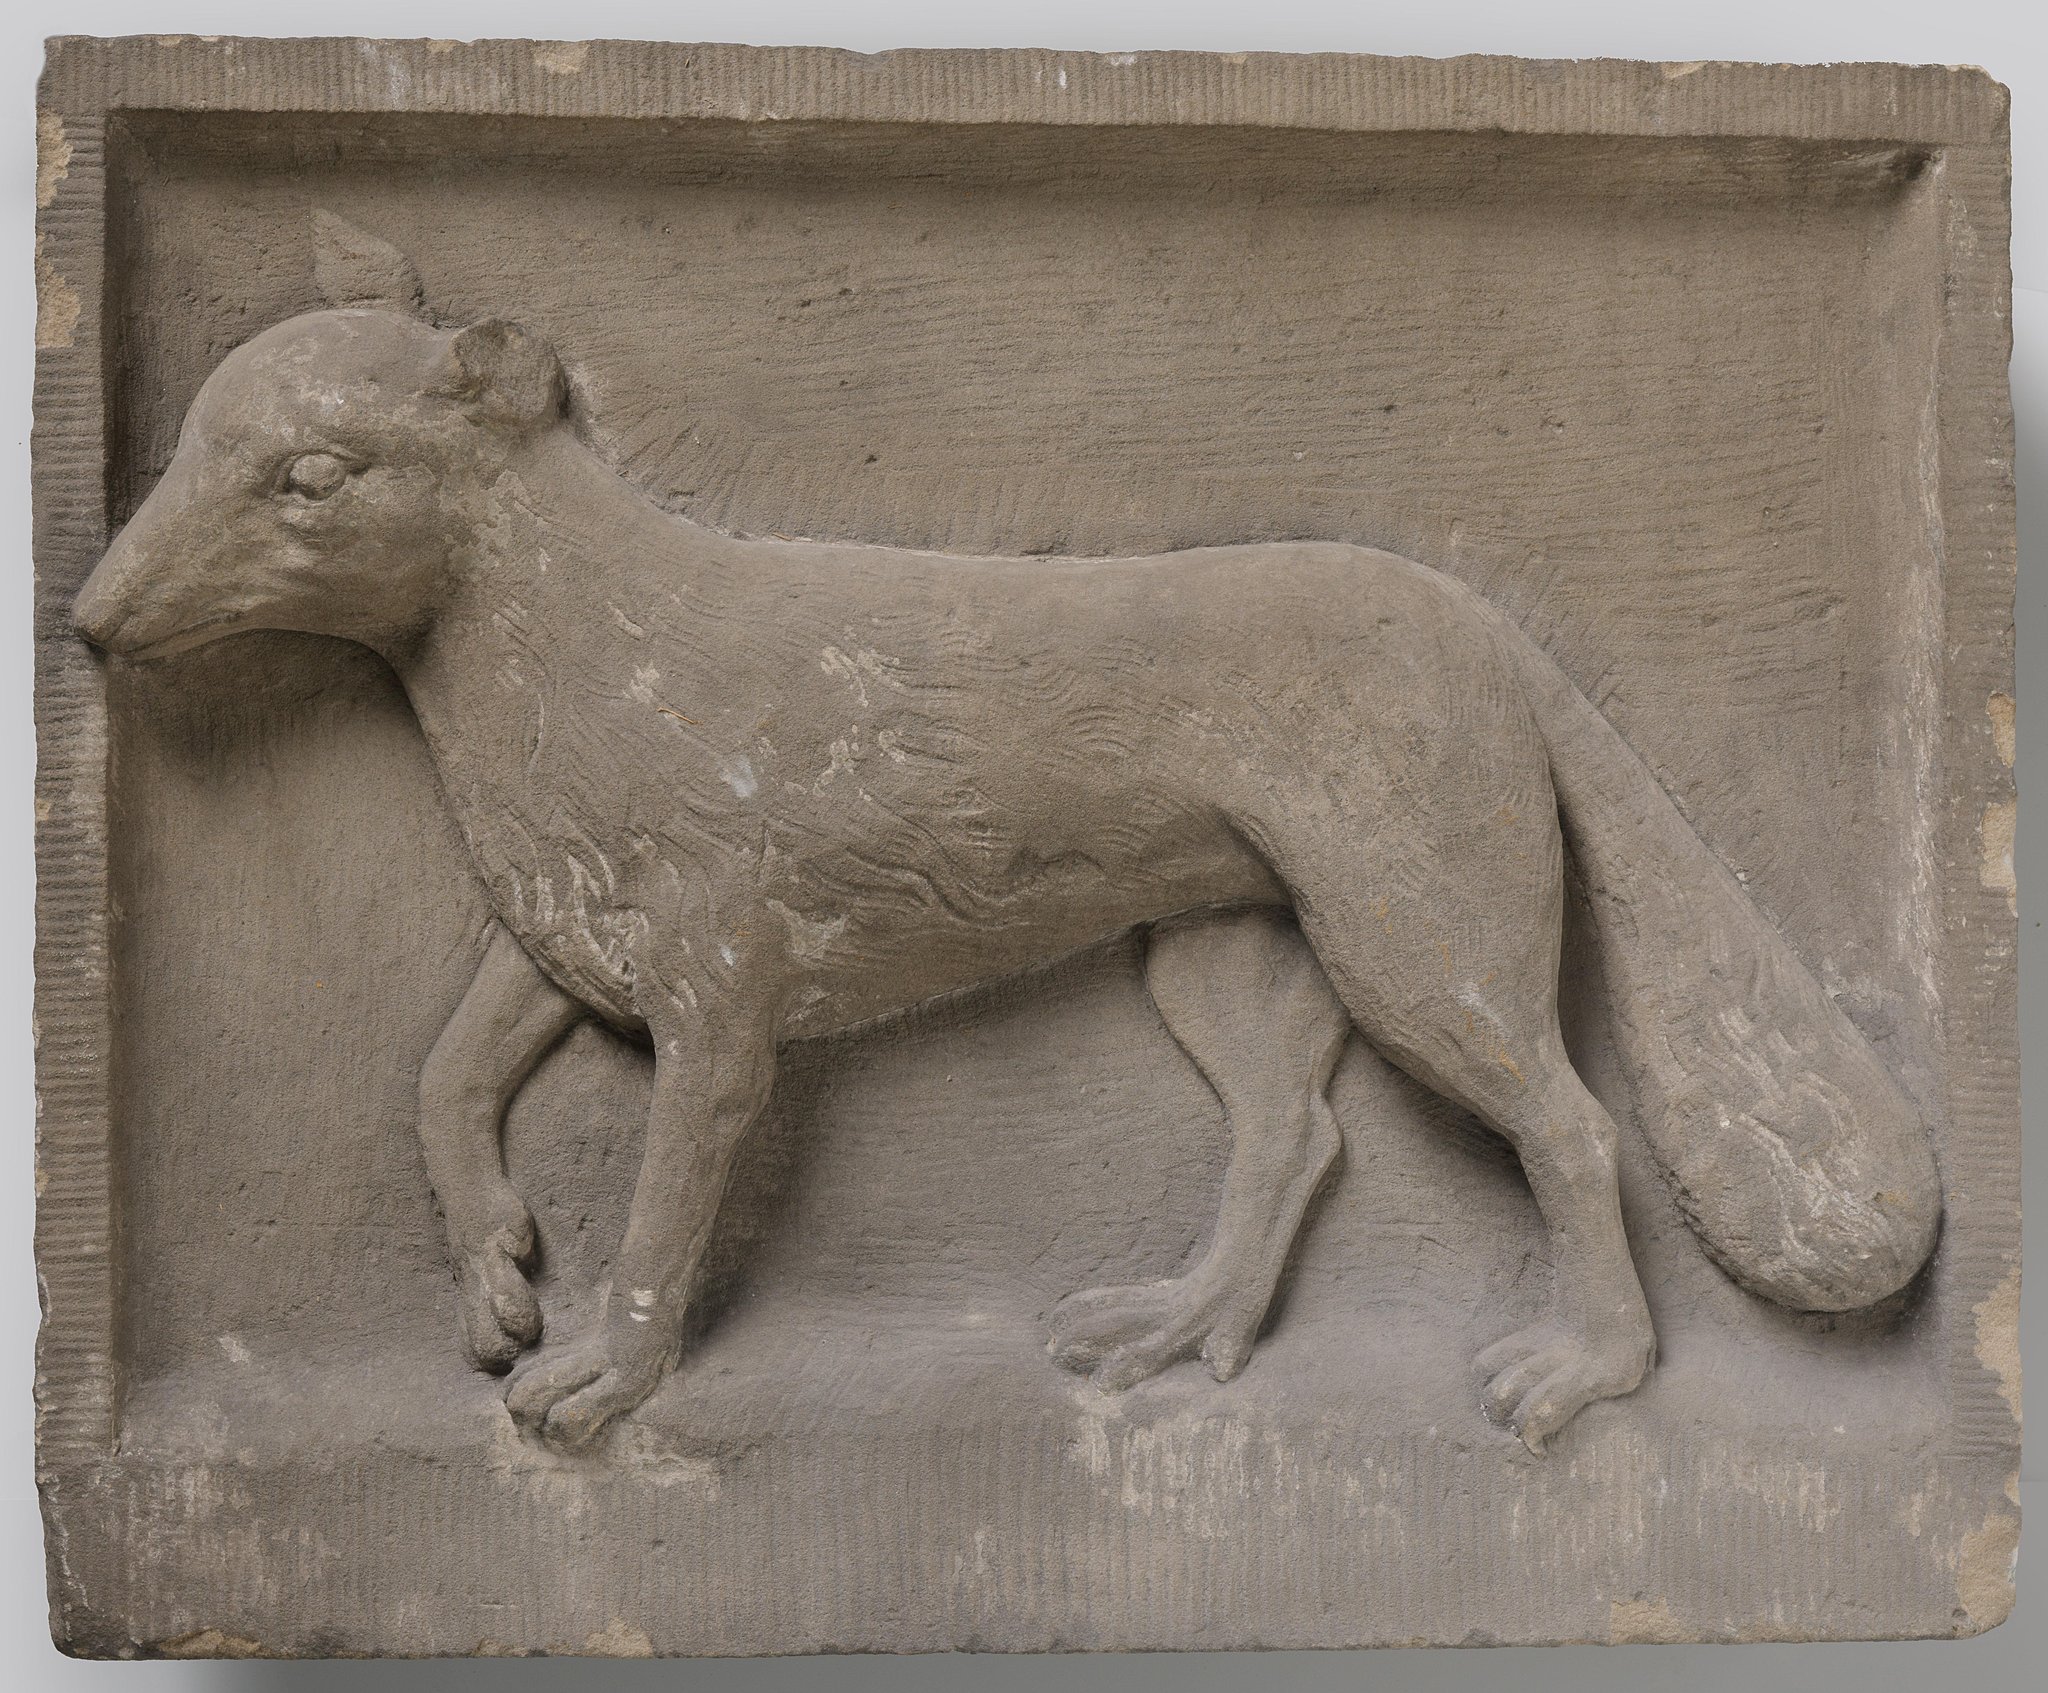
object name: gable stone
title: Gevelsteen met vos of wolf.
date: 1400-1950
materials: stone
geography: netherlands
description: Liggende rechthoek met een gearceerde rand en een afbeelding van een naar links gewend dier (vos of wolf?), ten voeten uit staand. Bij de steen hoort een steen met invnr. KOG-ALS-117-A.